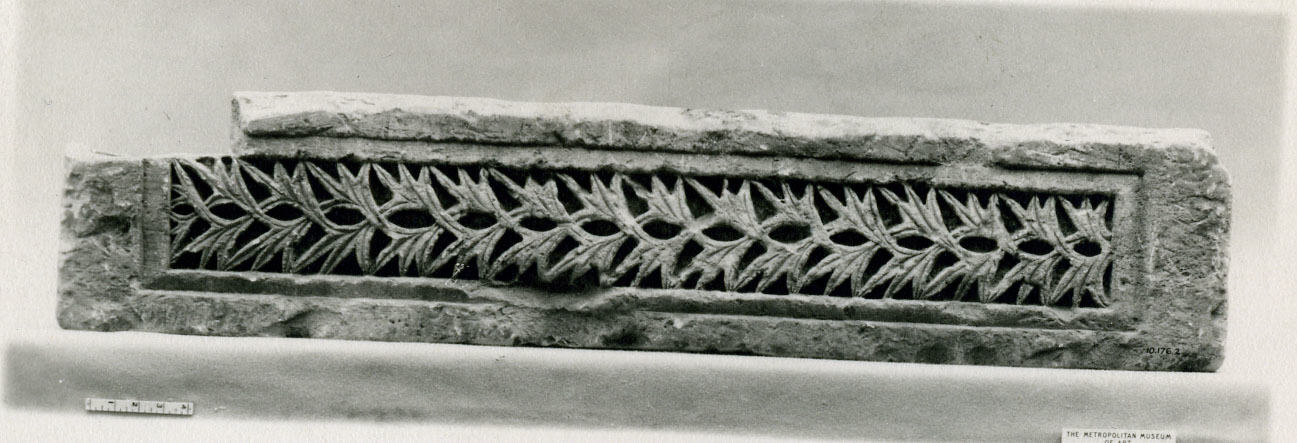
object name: fragment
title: Fragment with a Pattern of Interlaced Leaves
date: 501-600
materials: limestone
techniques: carving, relief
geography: egypt